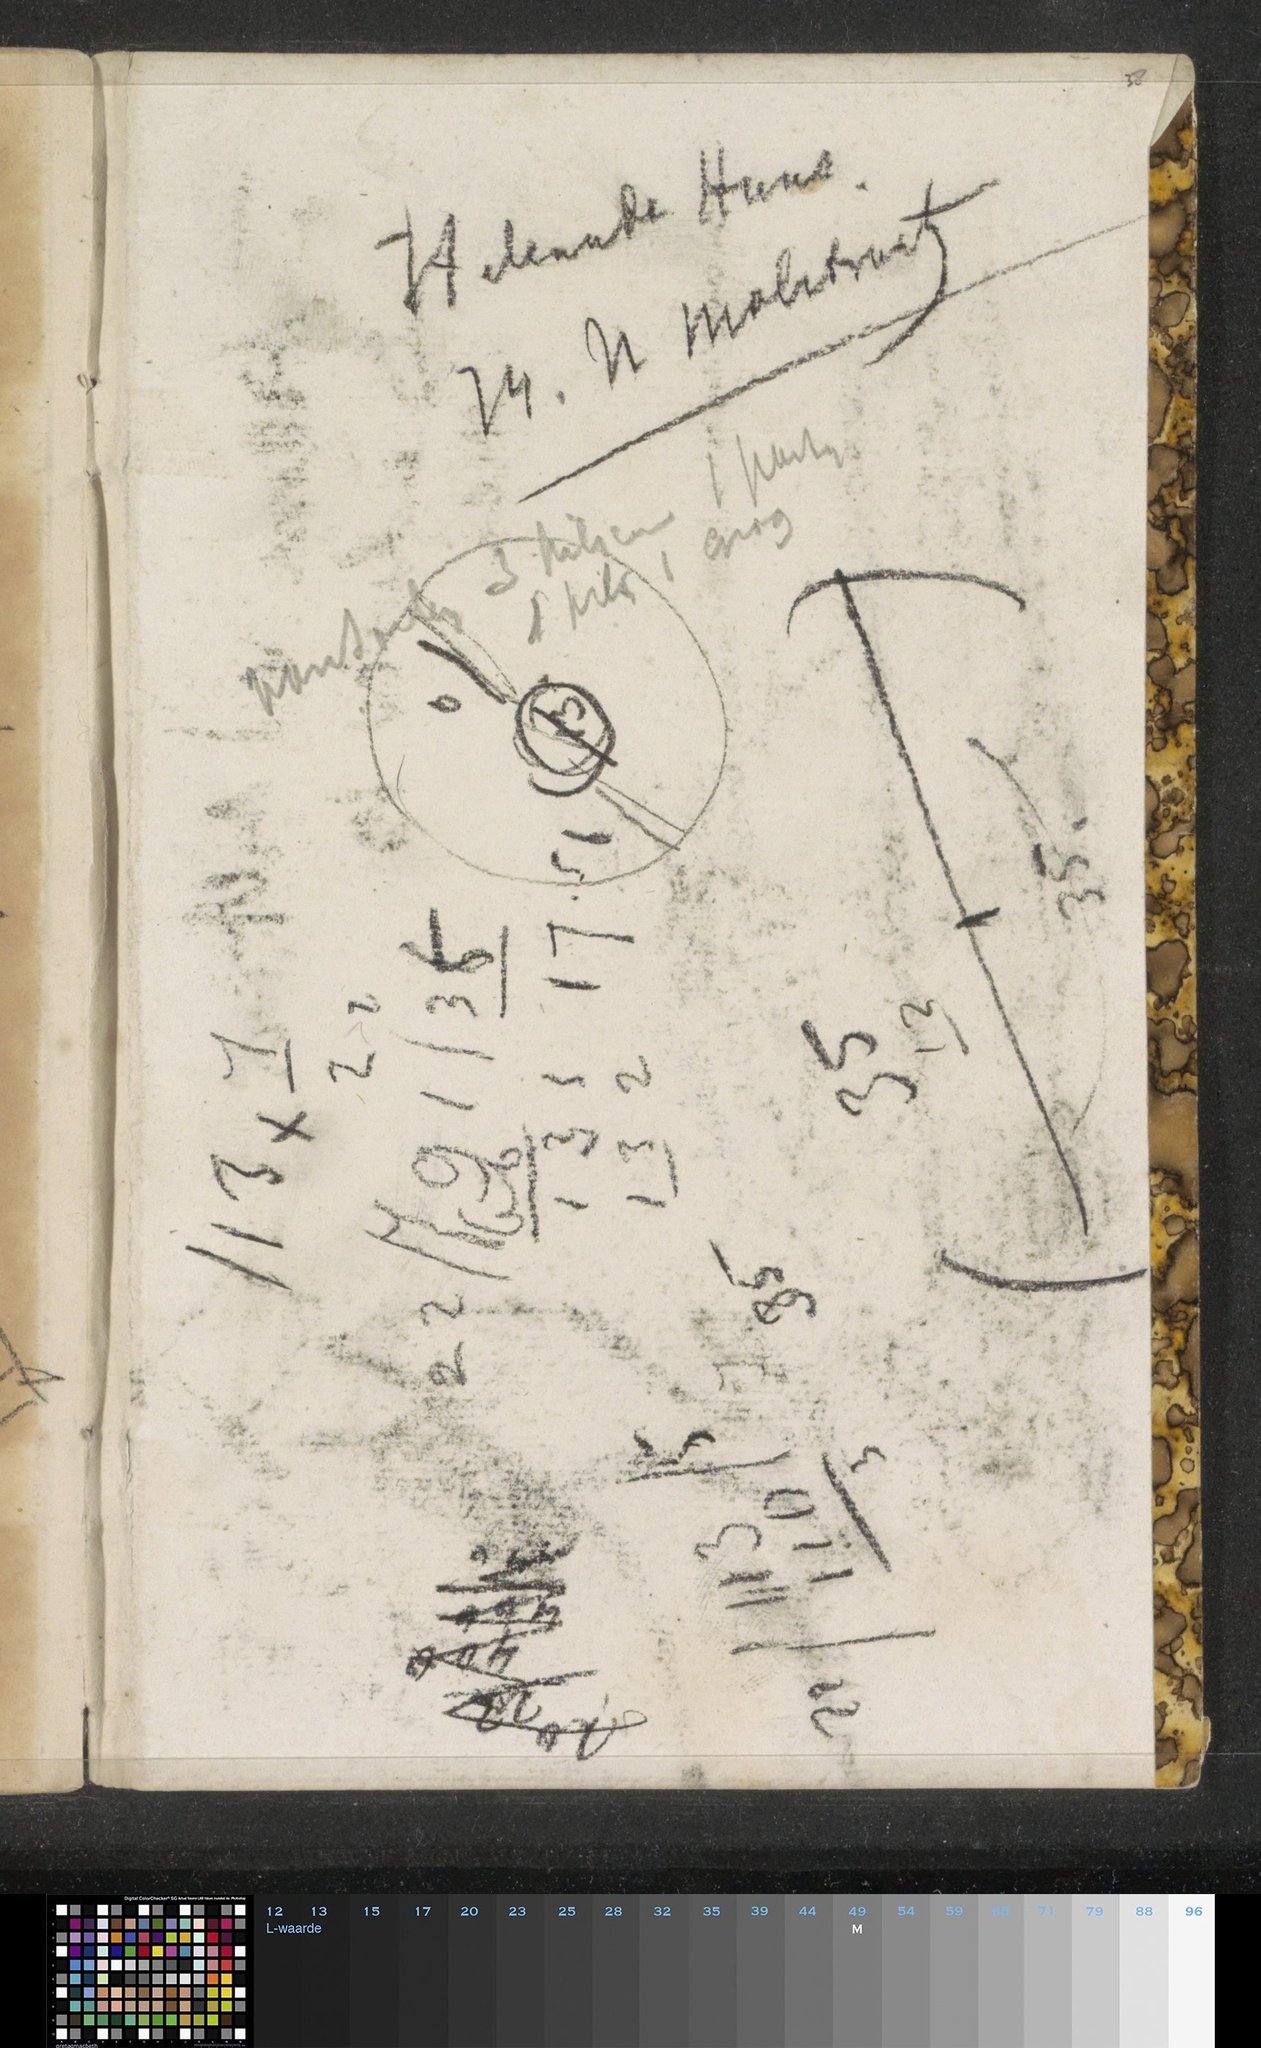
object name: sketchbook leaf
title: Studies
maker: george hendrik breitner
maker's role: draughtsman, painter, print maker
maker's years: 1857-1923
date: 1883-1885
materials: chalk, paper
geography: the hague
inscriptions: annotation: ‘[...]’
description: Pagina 38, achterste schutblad, uit een schetsboek met 18 bladen.